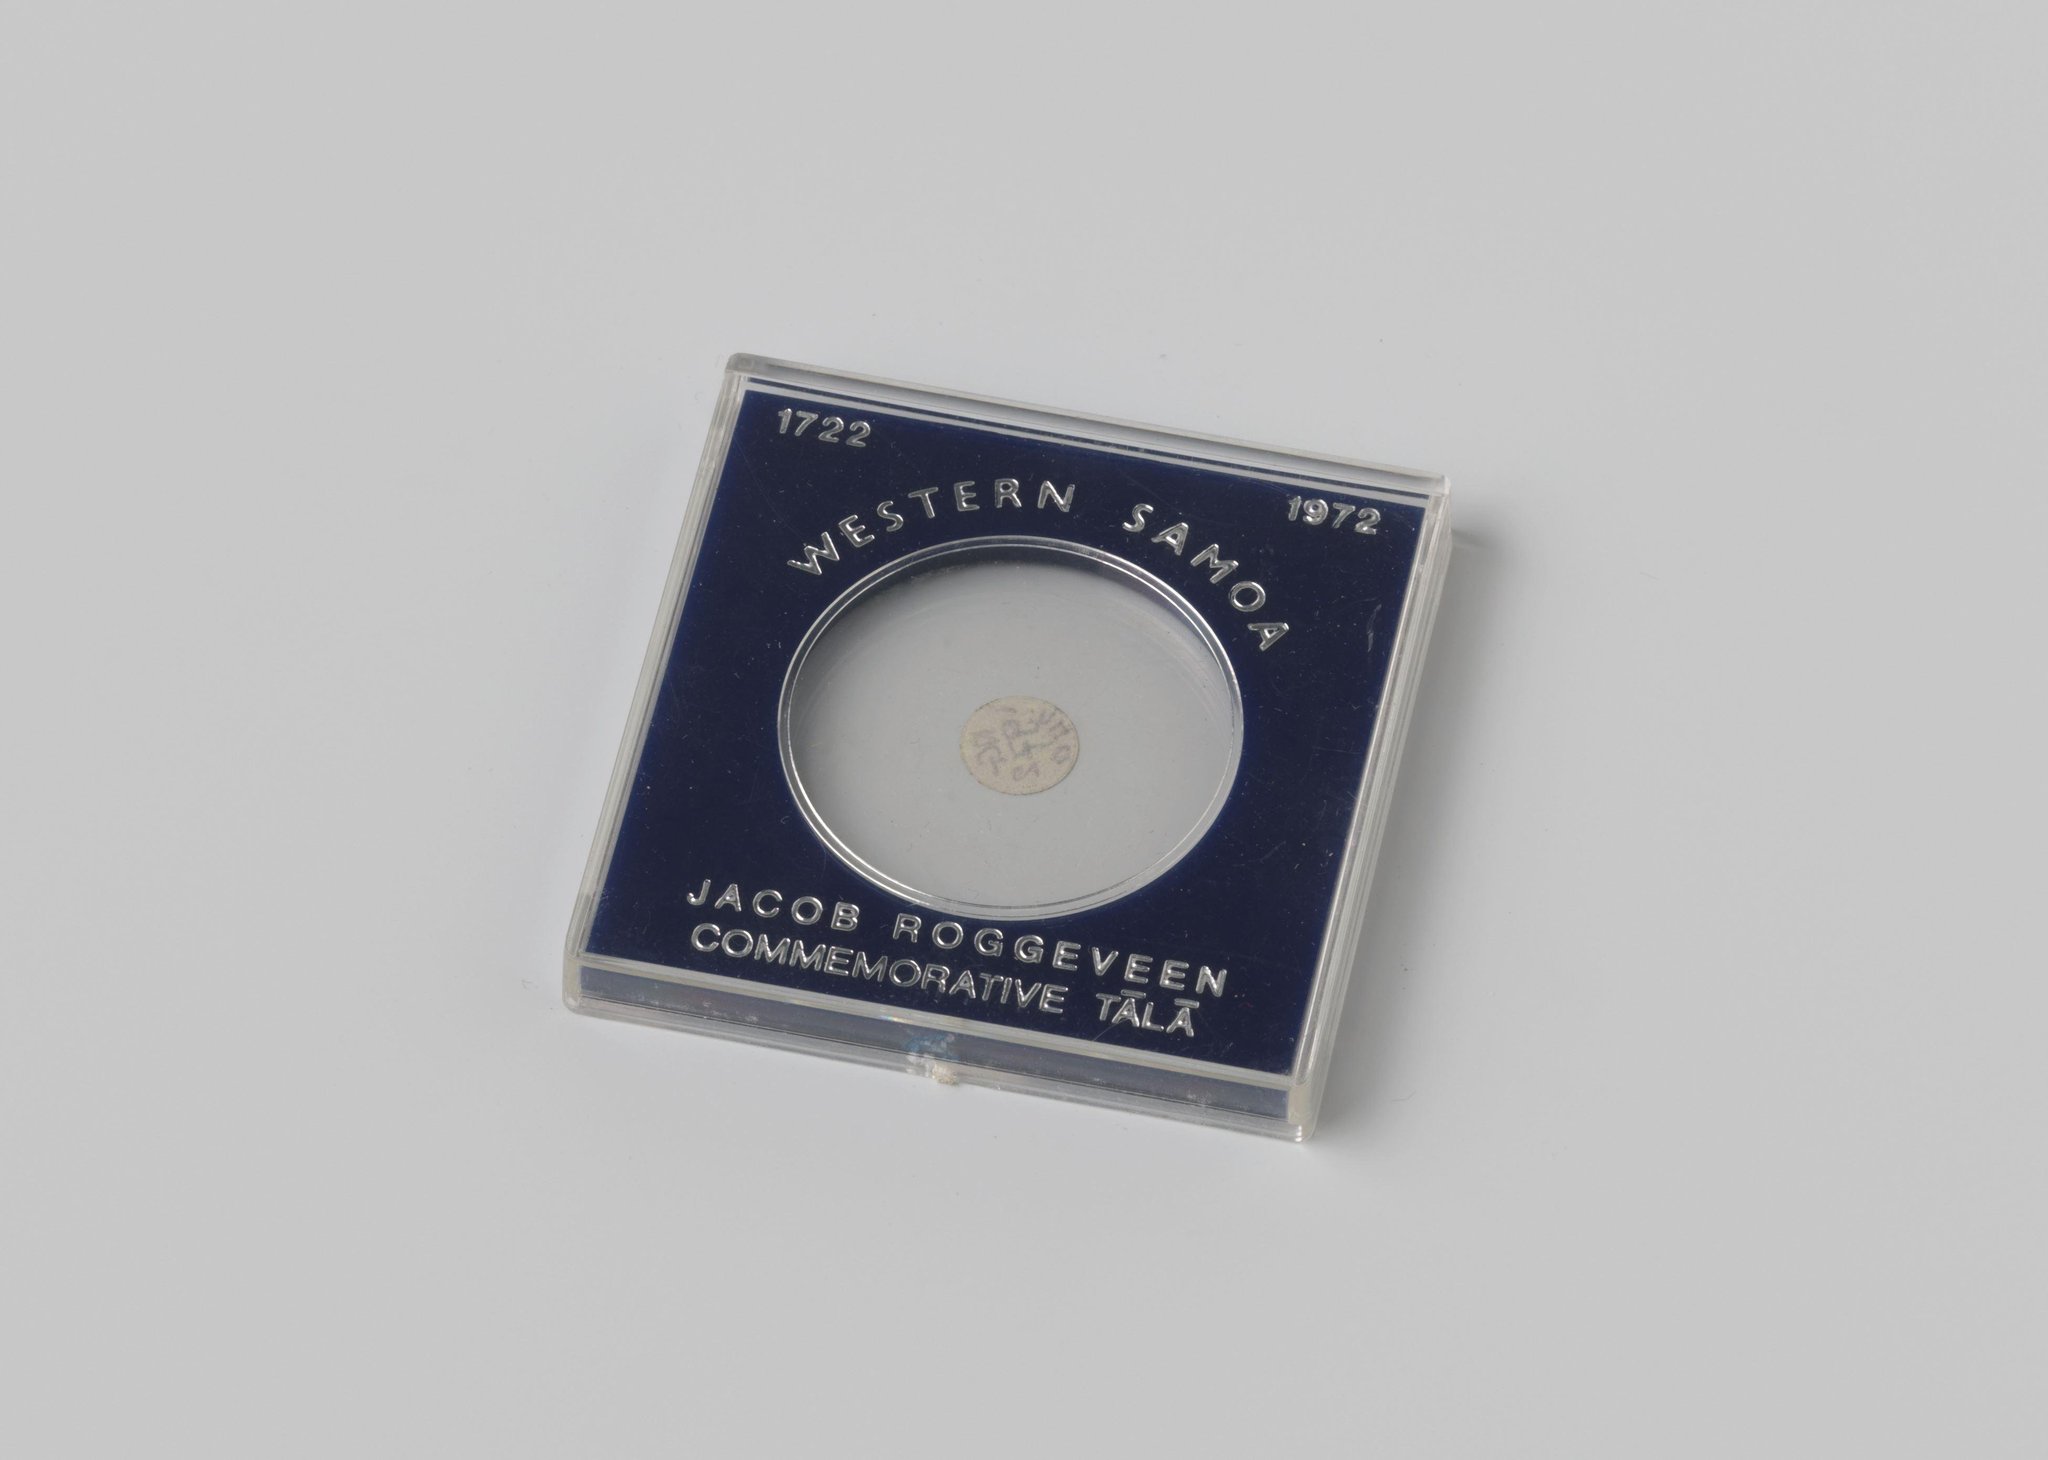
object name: box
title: Doos horend bij een nikkelen penning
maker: james berry o.b.e.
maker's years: 1906-1979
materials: plastic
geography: apia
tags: jacob roggeveen, upolu, savaii, ontdekking van samoa